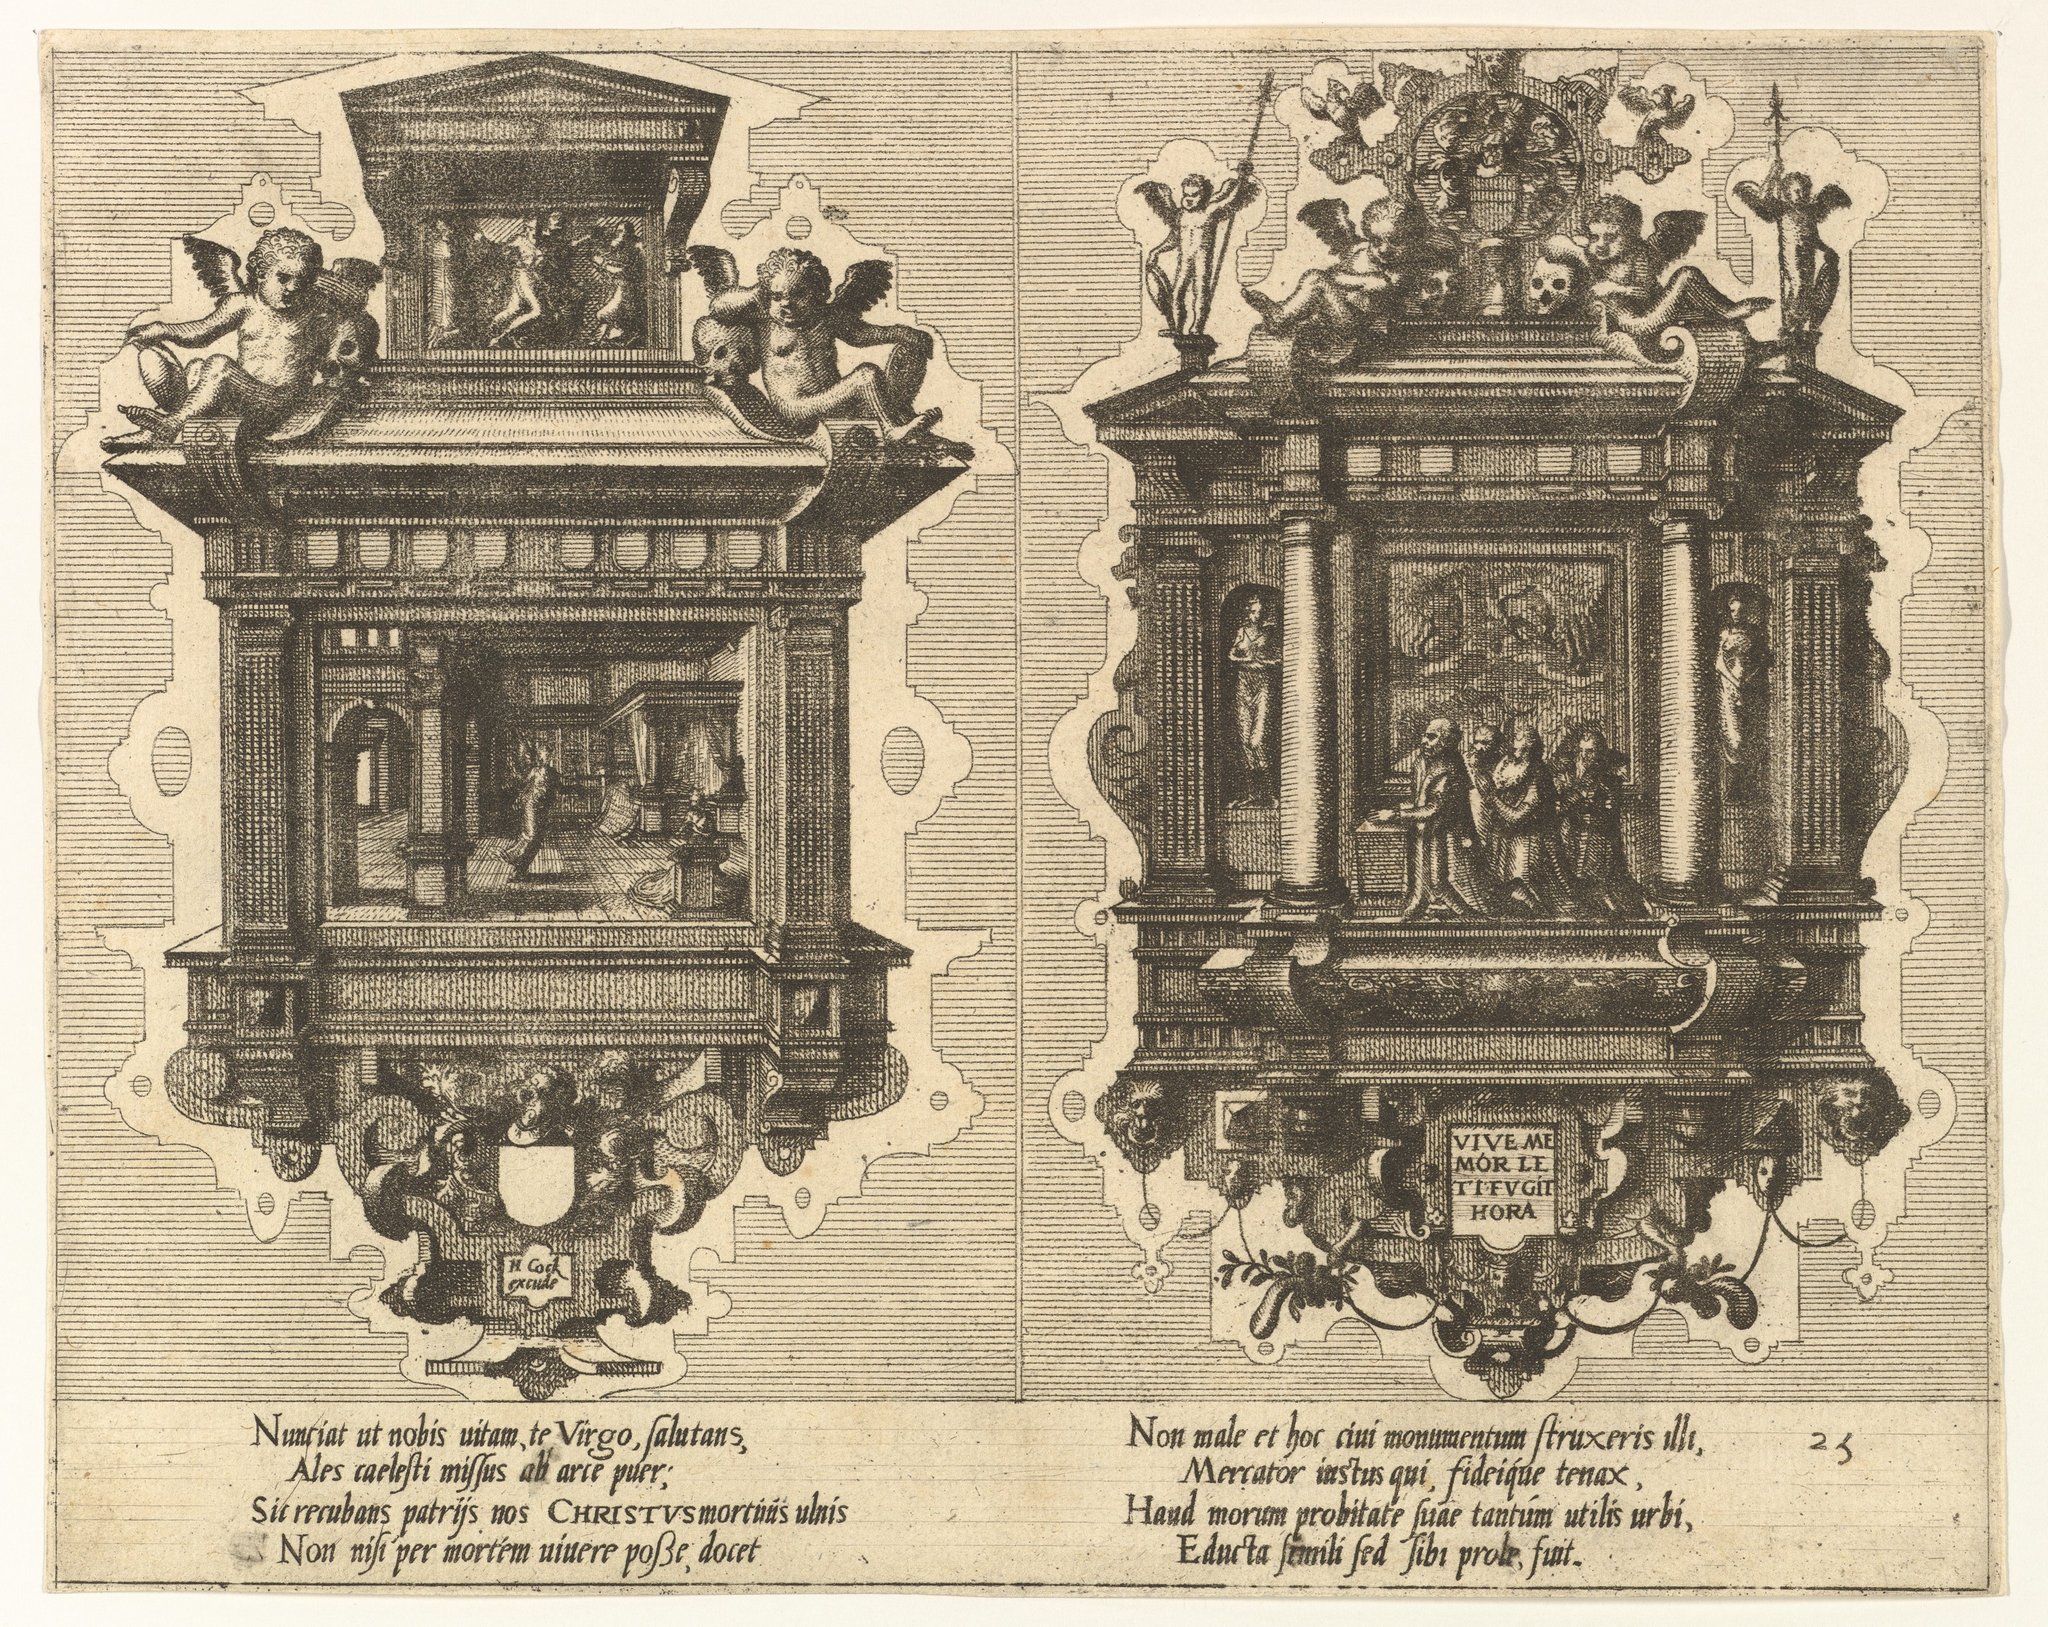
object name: collection ornament architecture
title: Cœnotaphiorum (25)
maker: hans vredeman de vries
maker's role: artist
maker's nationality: netherlandish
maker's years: 1527-1606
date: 1563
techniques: etching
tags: monuments,annunciation